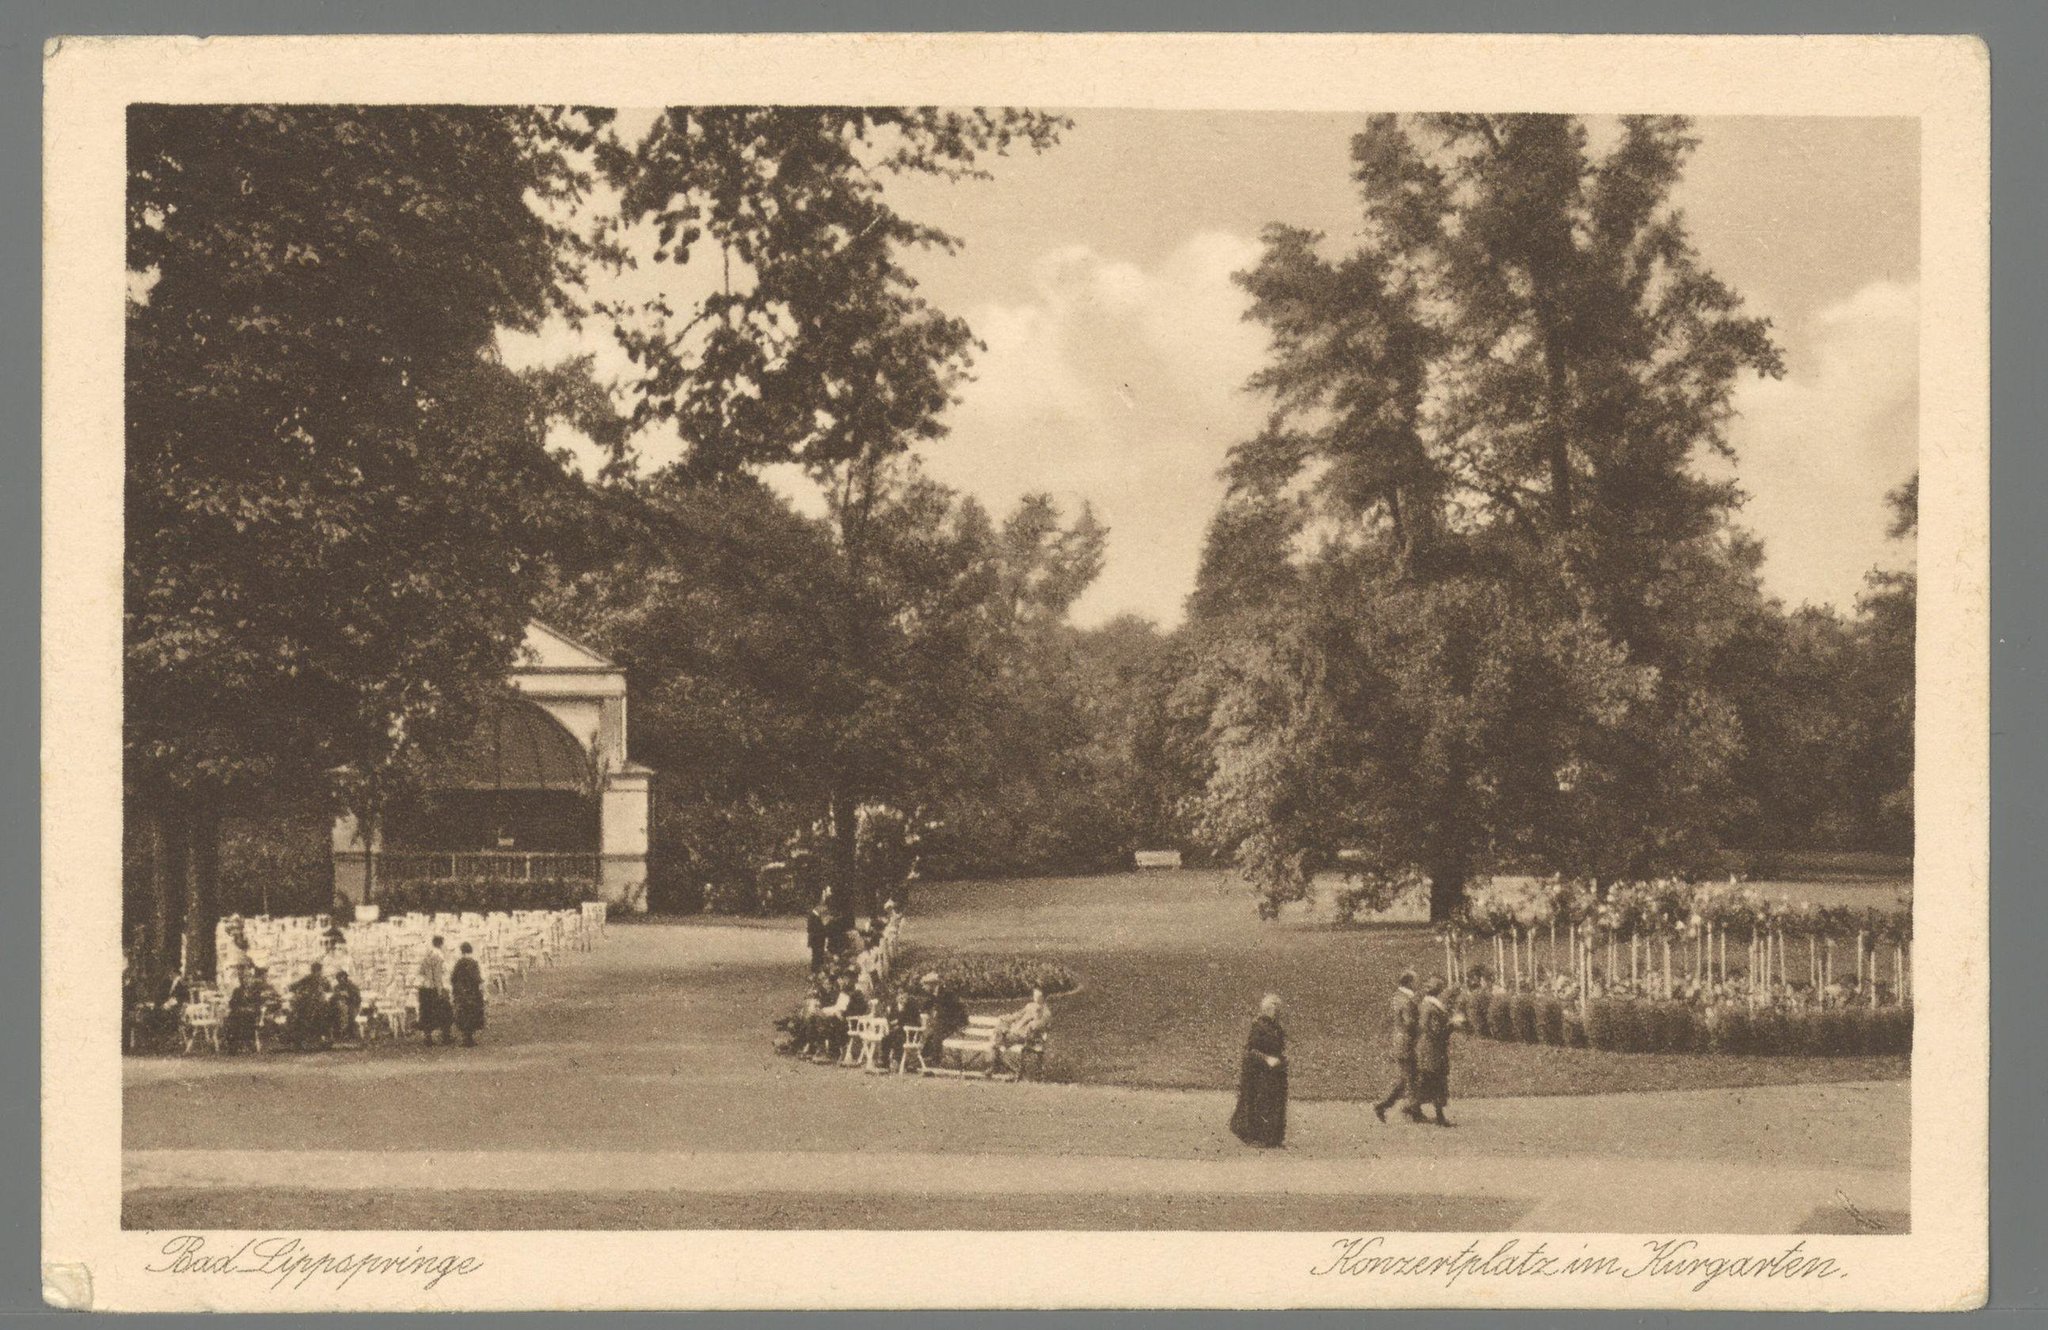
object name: ansichtkaart, prentbriefkaart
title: Bad Lippspringe. Konzertplatz im Kurgarten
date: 1905-1930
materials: cardboard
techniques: rotogravure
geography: dortmund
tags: park, watering-place, spa